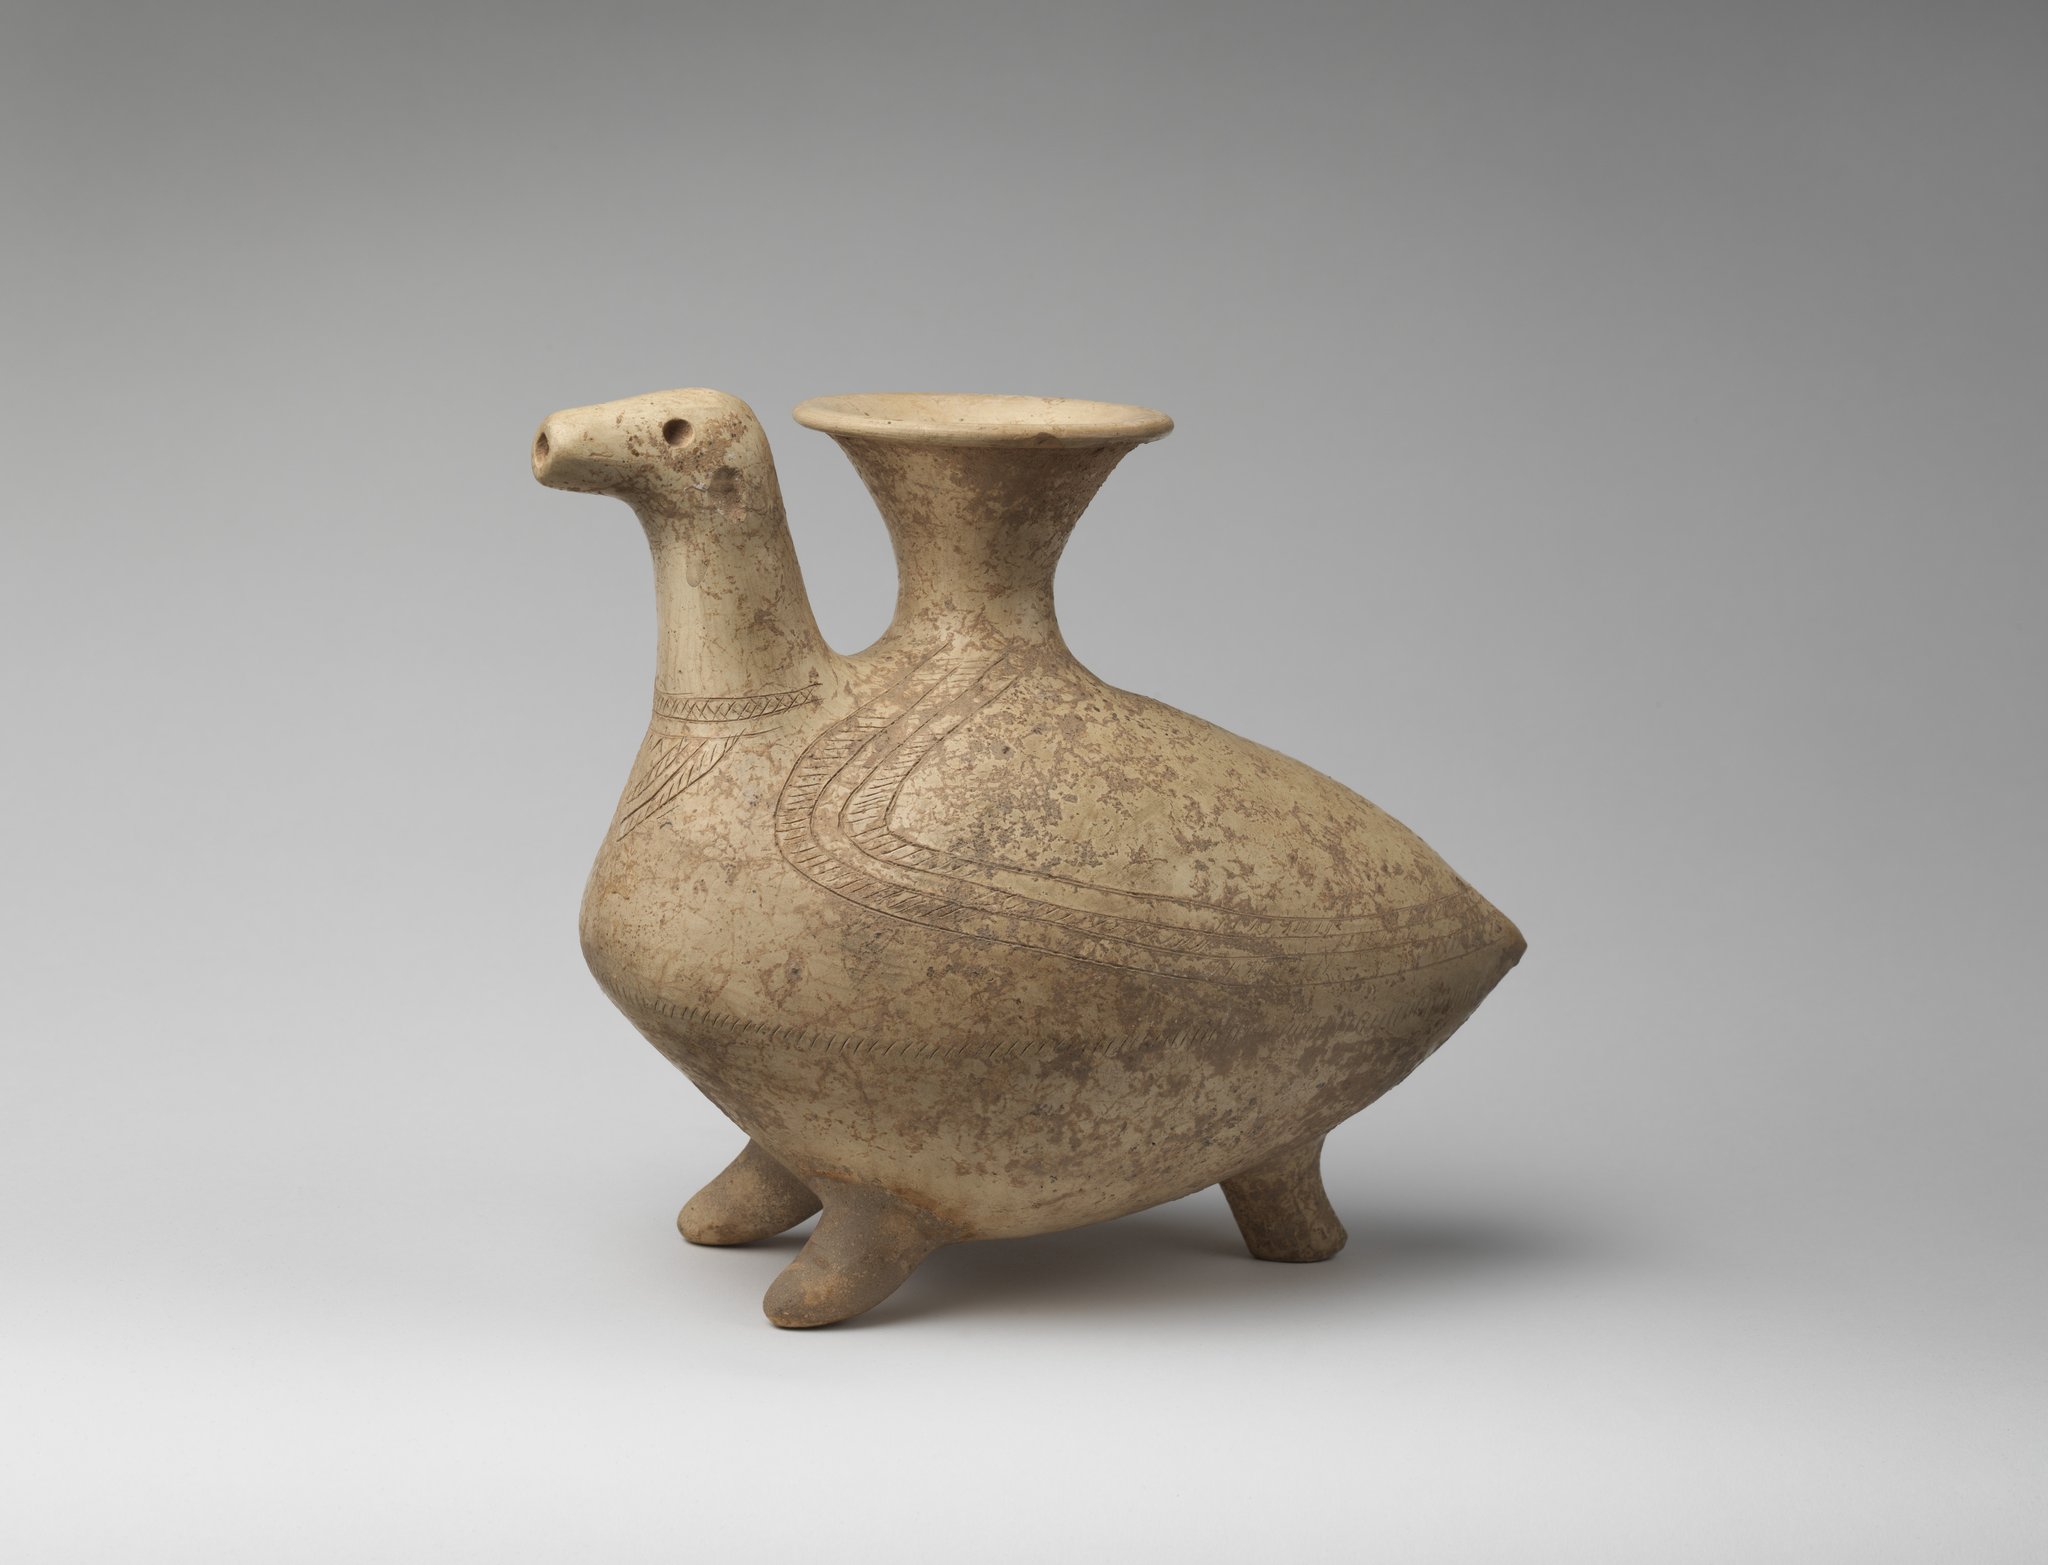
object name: rhyton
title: Rhyton in the shape of a bird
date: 1000-668 BCE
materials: ceramic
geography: northwestern iran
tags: ducks